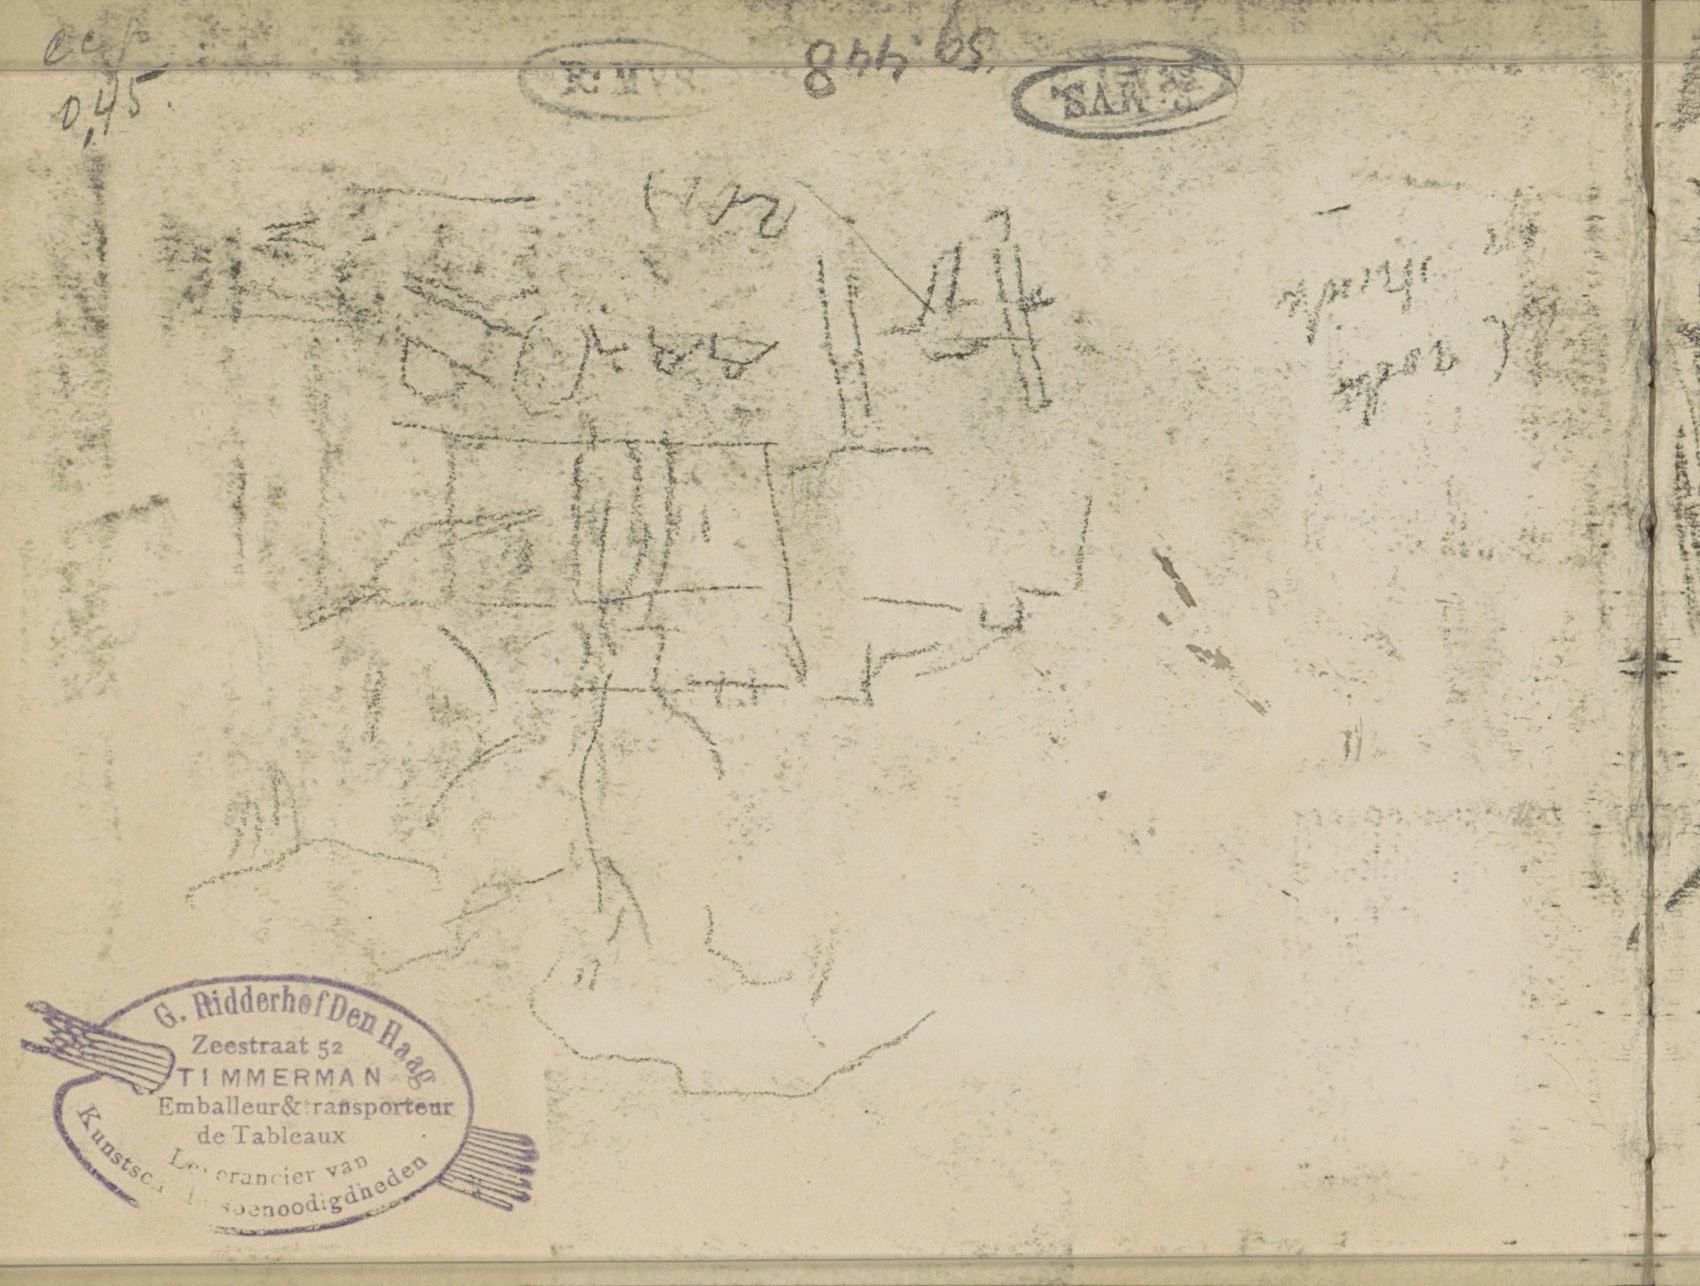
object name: endleaf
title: Gebouwen in een landschap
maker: johan antonie de jonge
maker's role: draughtsman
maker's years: 1864-1927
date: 1881-1927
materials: chalk, paper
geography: south holland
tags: trees, civic architecture; edifices; dwellings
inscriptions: annotation: ‘cent[?]/ 0,45’, collector's mark: Lugt 2228, retailer's mark: ‘G. Ridderhof Den Haag/ Zeestraat 52/ Timmerman/ Emballeur & transporteur/ de Tableaux/ Leverancier van/ Kunstenaarsbenodigdheden’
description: Gebouwen in een landschap. Voorste schutblad uit een schetsboek met 34 bladen.